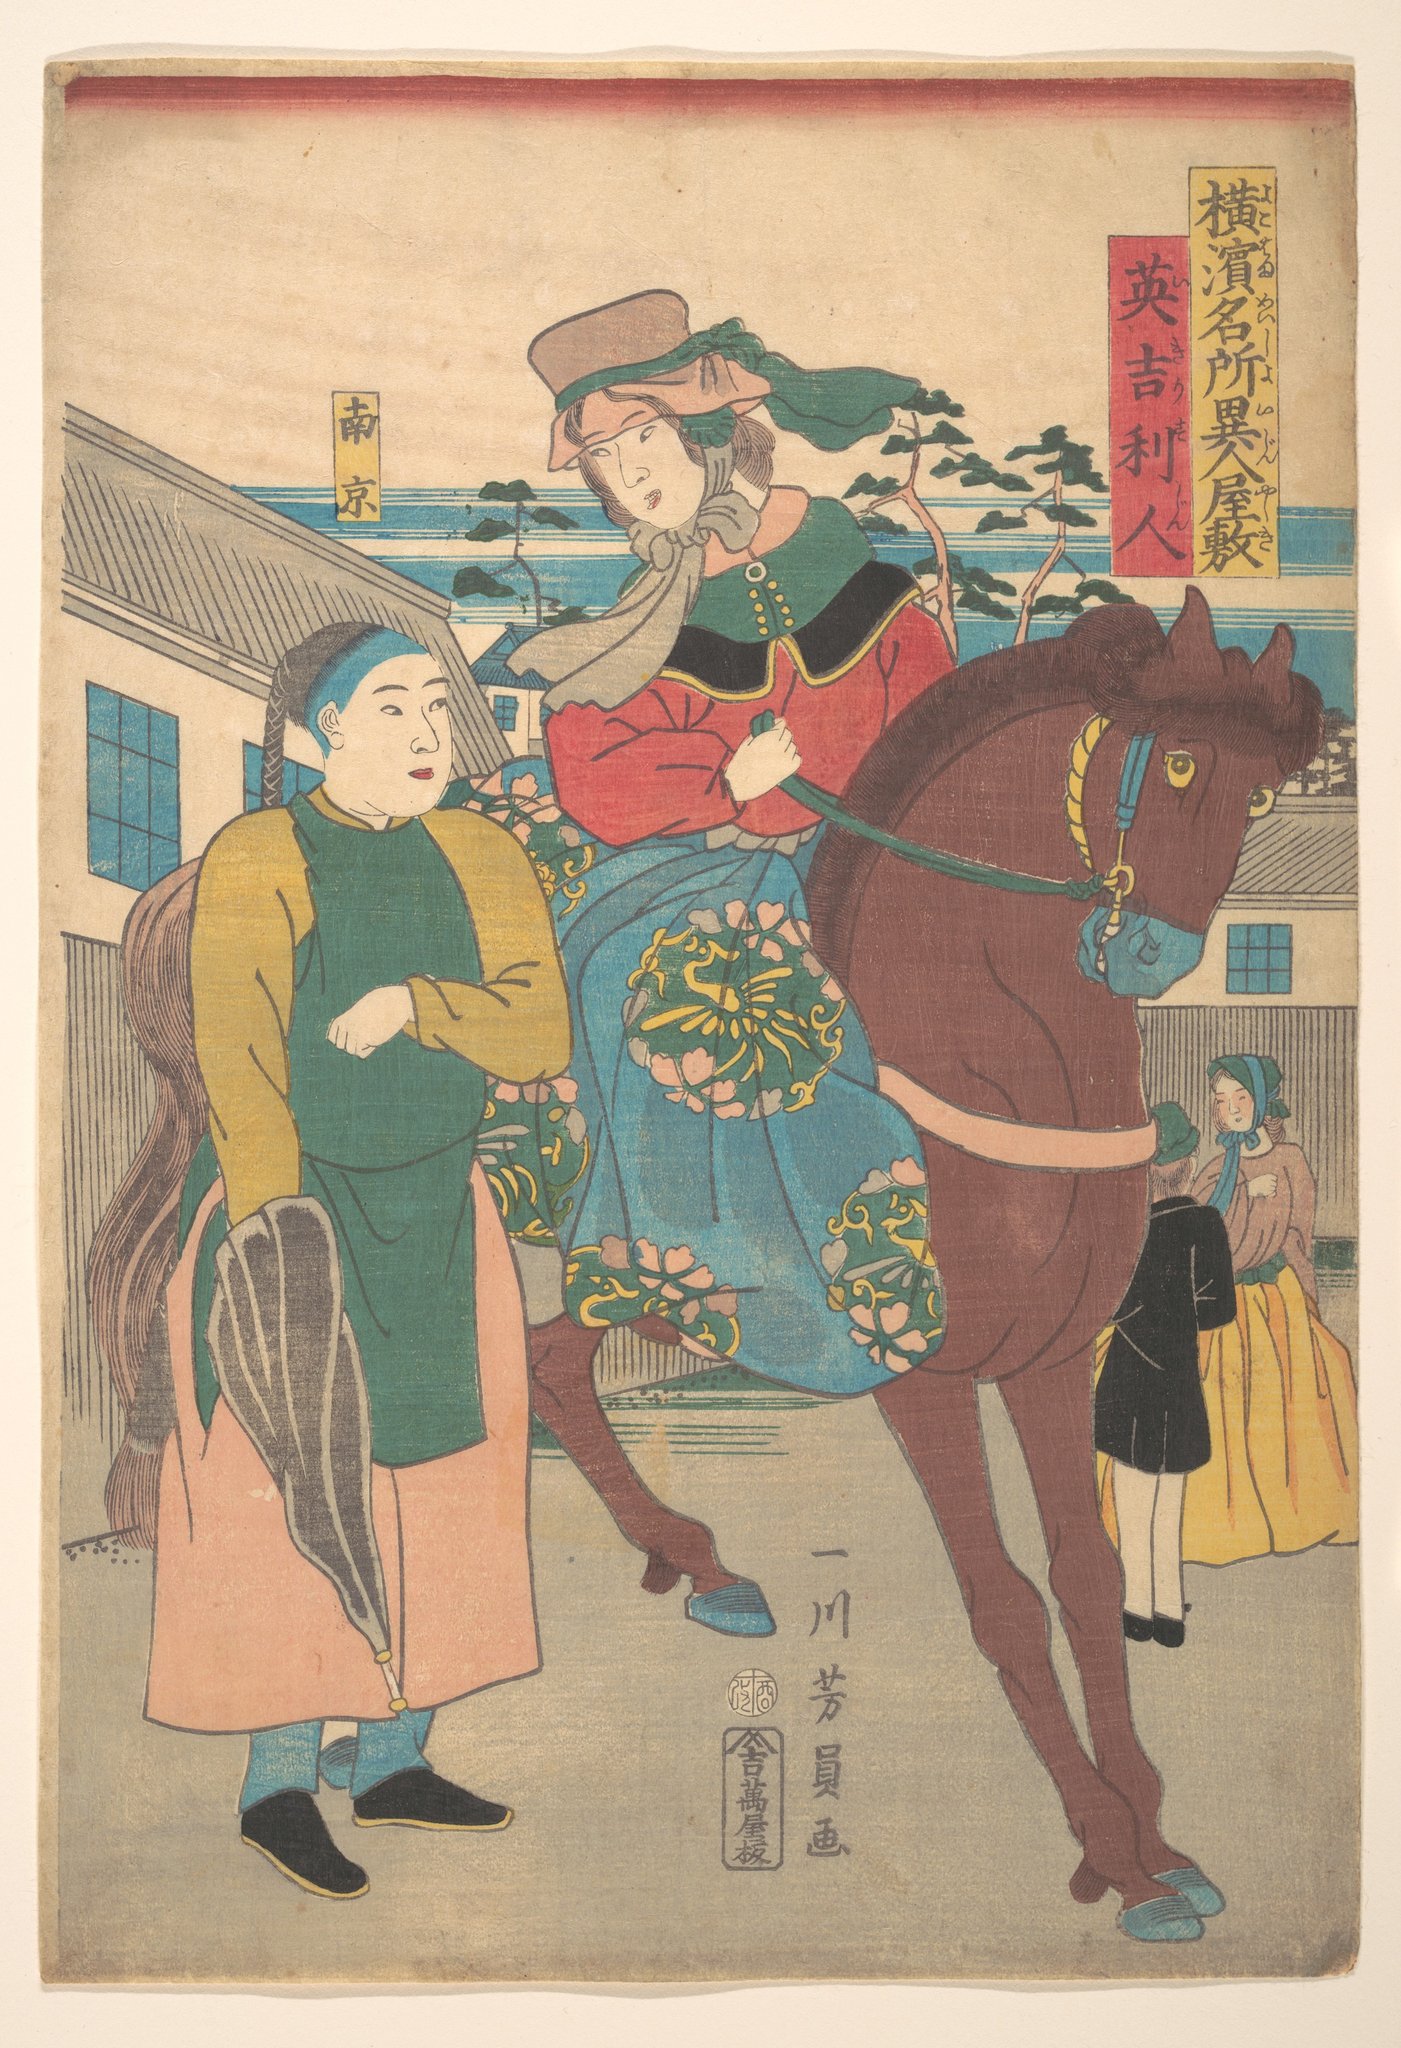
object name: print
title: An English Woman with a Chinese Servant in the Foreign District, from the series Famous Places in Yokohama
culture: japanese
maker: utagawa yoshikazu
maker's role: artist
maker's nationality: japanese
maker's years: 1845-1870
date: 1861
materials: ink, paper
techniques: woodblock print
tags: women,horses,servants